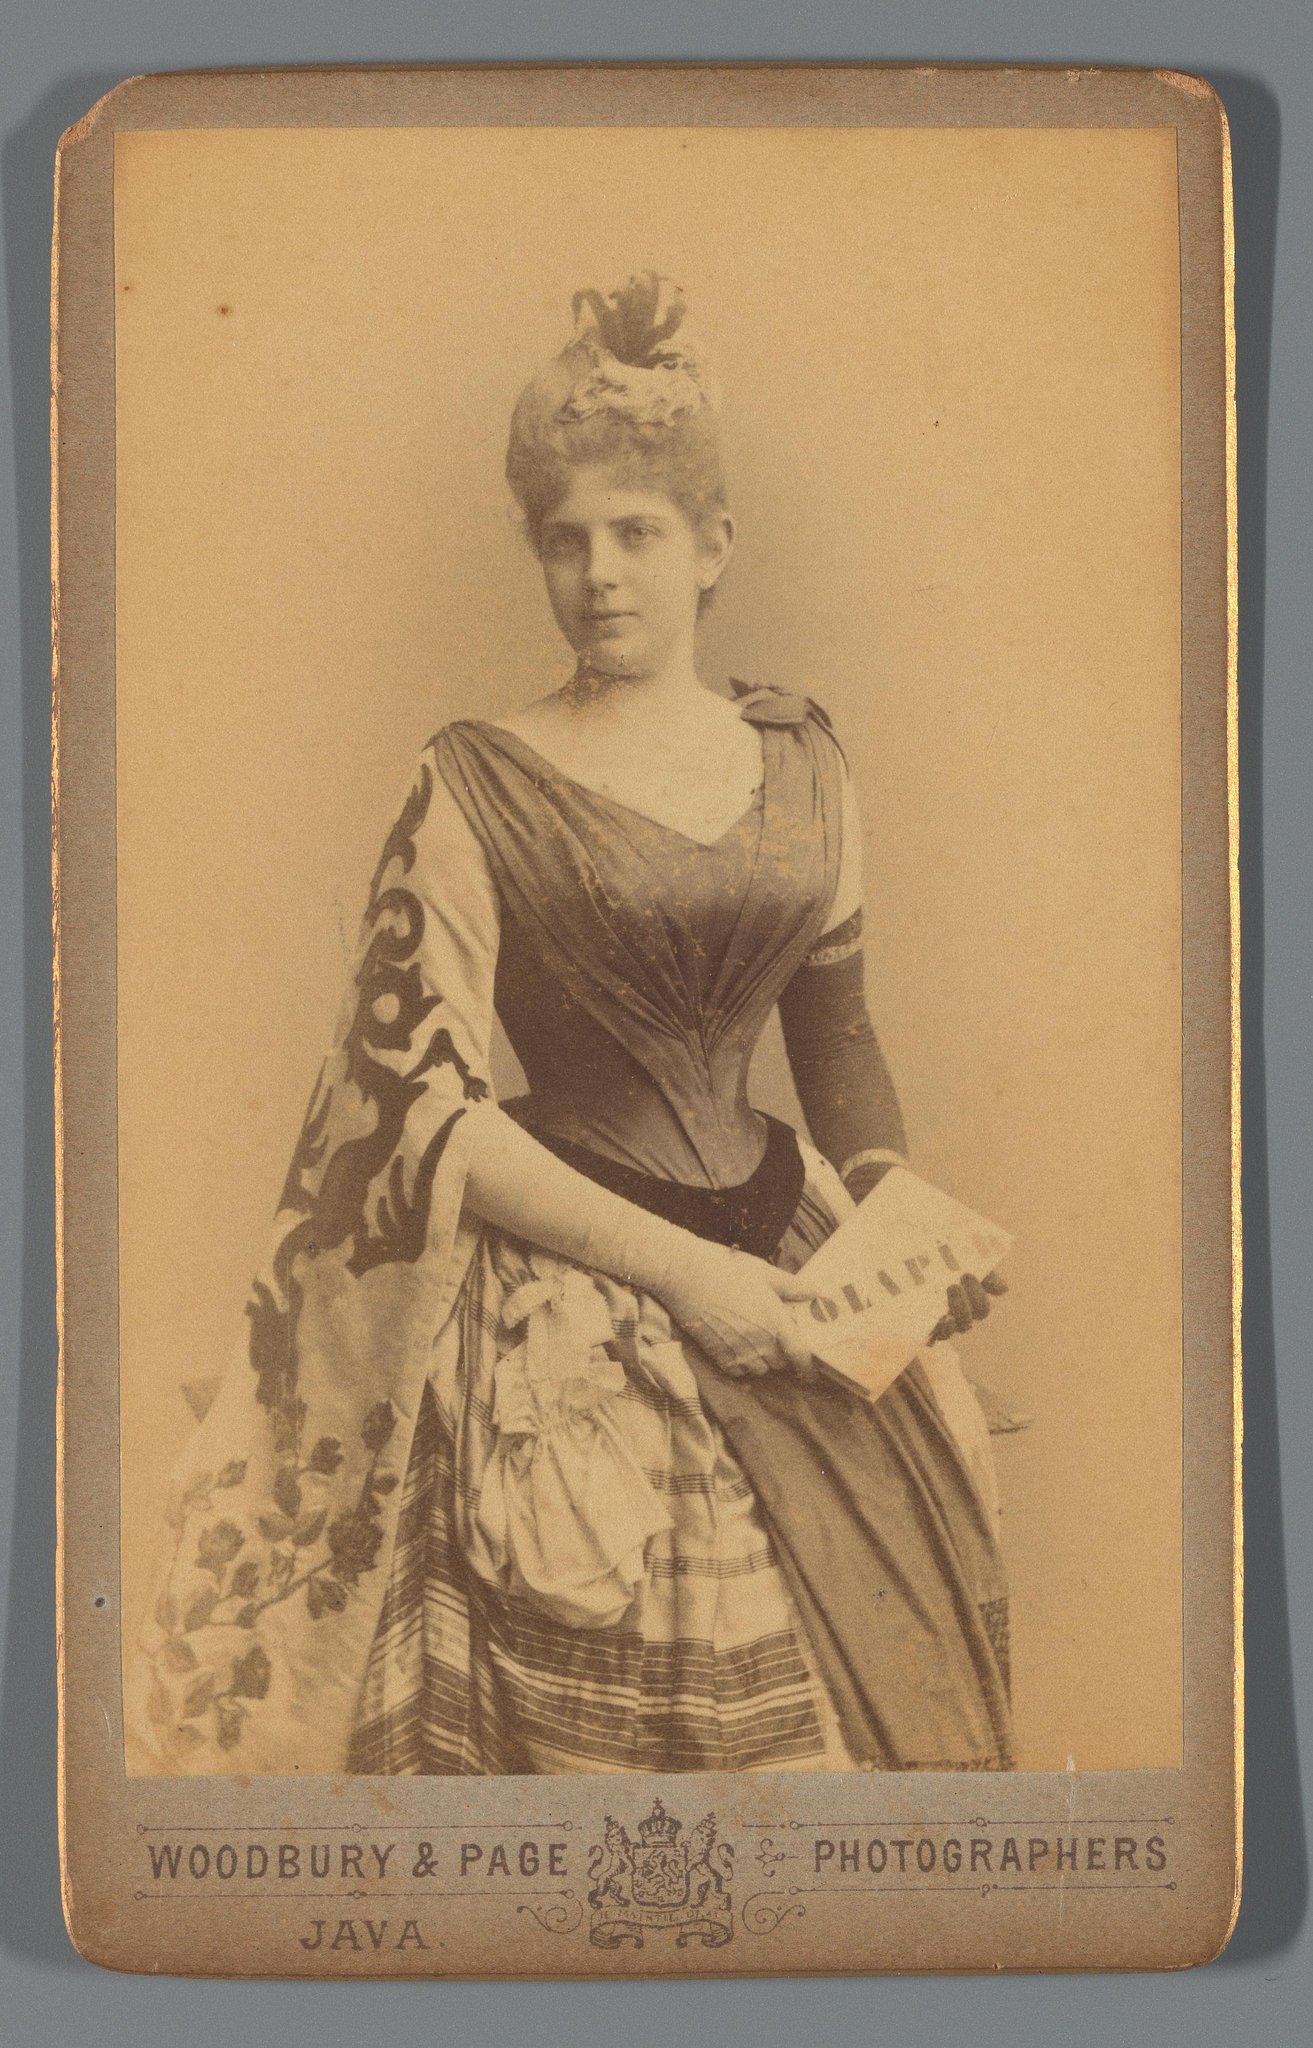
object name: photograph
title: Studioportret van Pauline van den Berg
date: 1870-1900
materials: cardboard, photographic support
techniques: albumen print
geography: java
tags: batavia, the hague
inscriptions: name: ‘WOODBURY & PAGE PHOTOGRAPHERS / JAVA’, name: ‘WOODBURY & PAGE / PHOTOGRAPHERS / JAVA.’, inscription: ‘Pauline van den Berg’